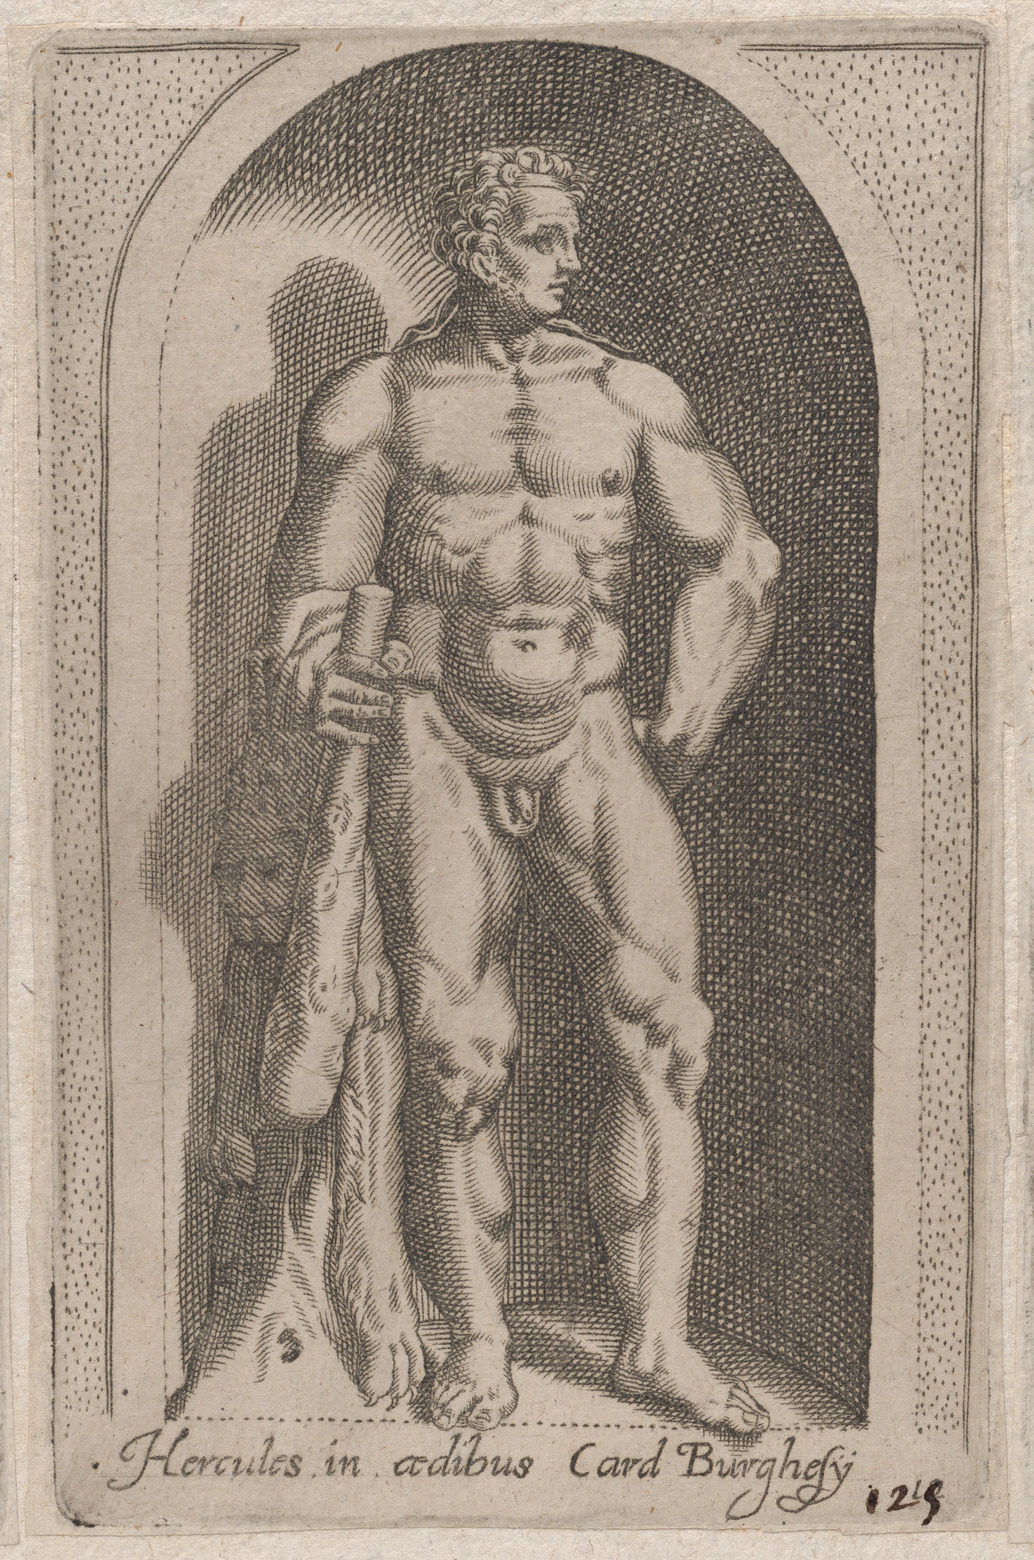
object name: print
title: Hercules (Hercules in aedibus Card. Burghesij), from "Speculum Romanae Magnificentiae"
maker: Anonymous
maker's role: artist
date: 1501-1600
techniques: engraving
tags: hercules